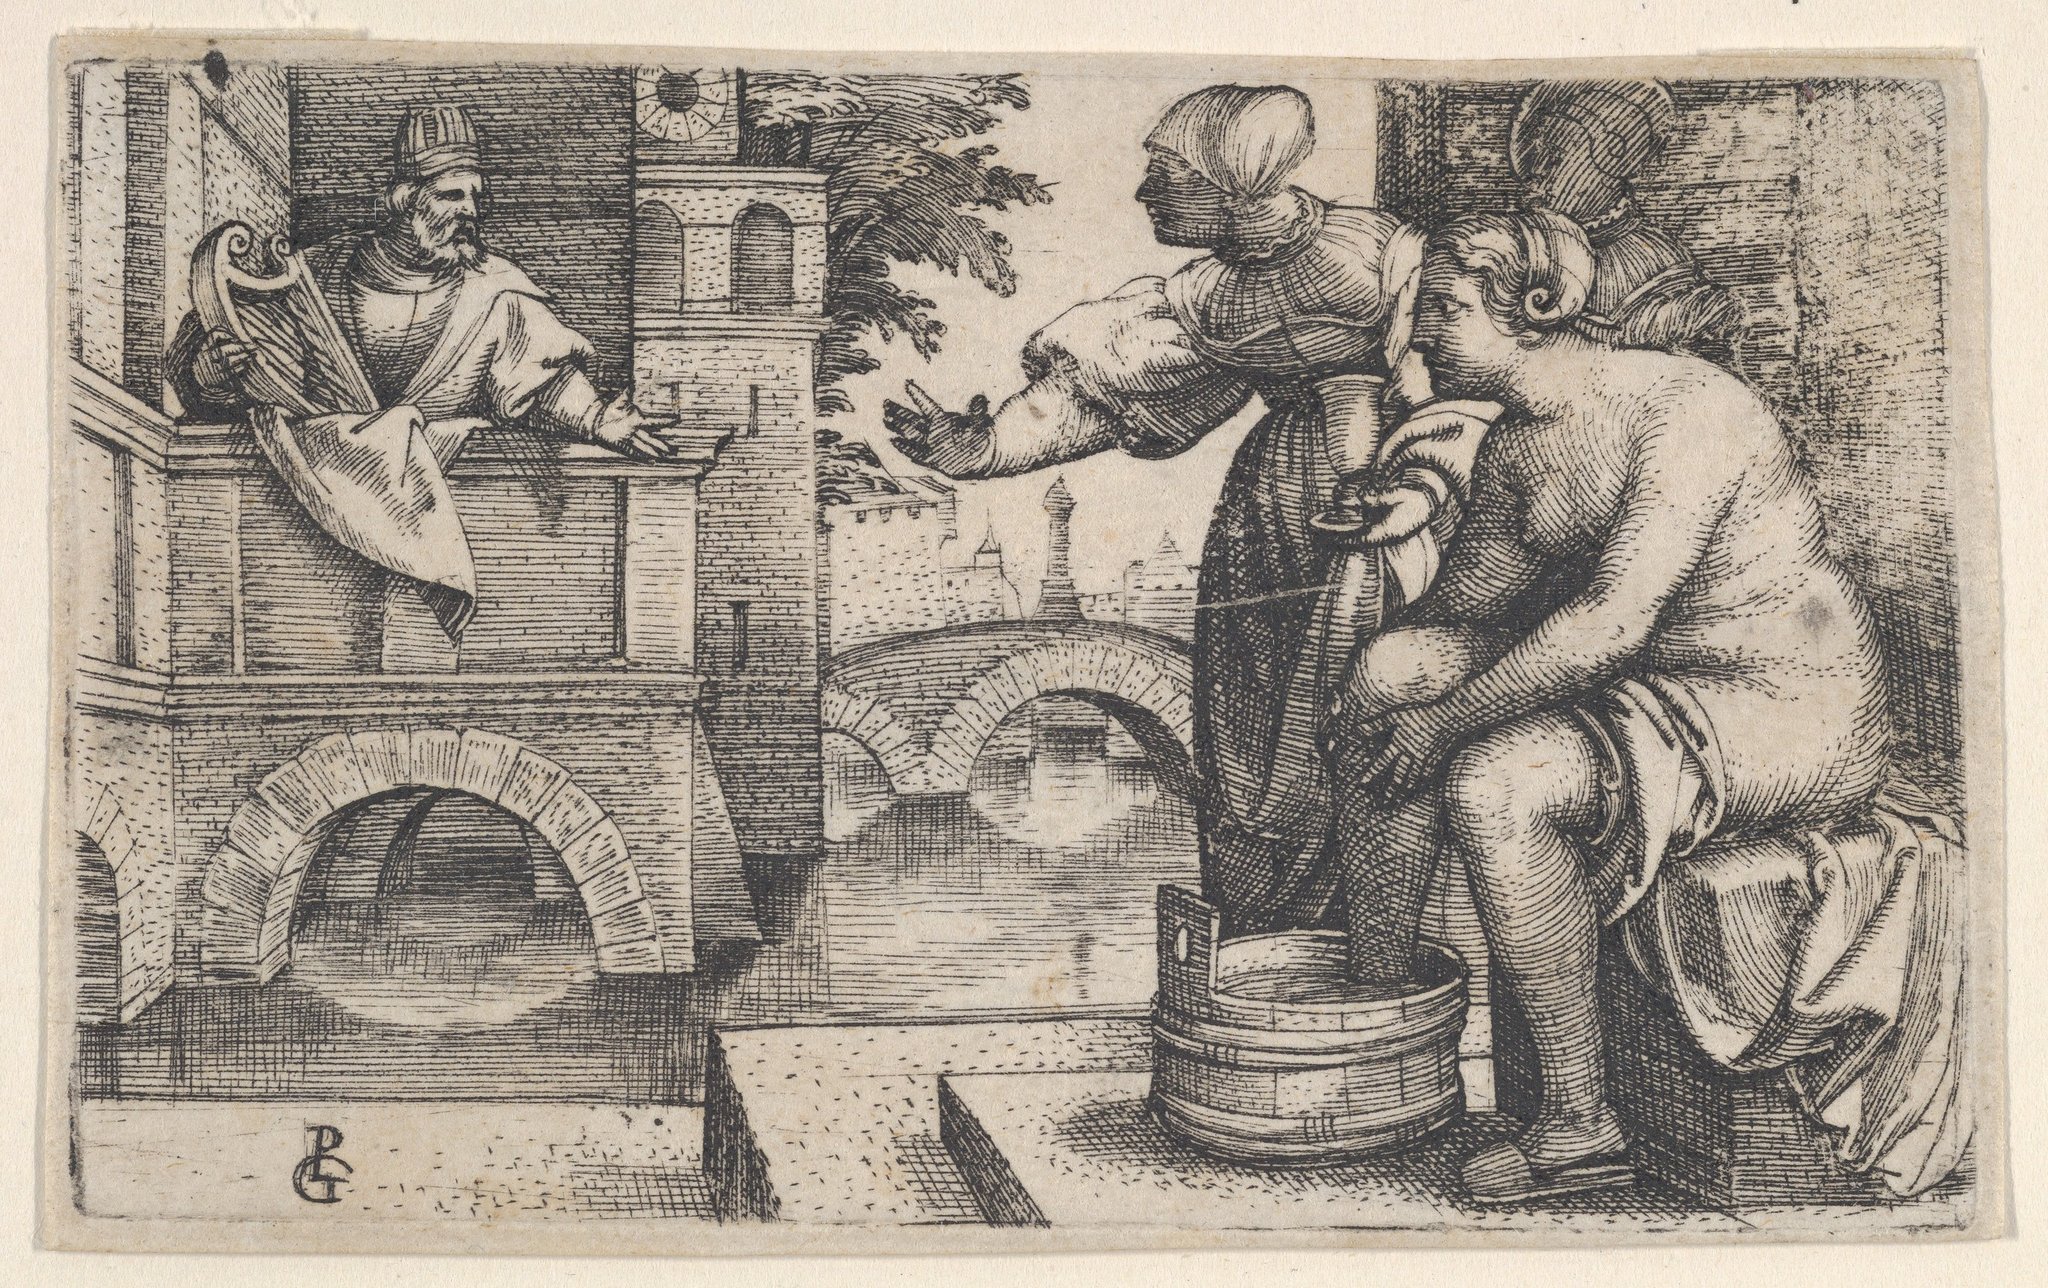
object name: print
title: David and Bathsheba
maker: georg pencz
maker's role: artist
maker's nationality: german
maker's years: 1500-1550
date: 1526-1536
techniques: engraving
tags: bathsheba,david,bathing